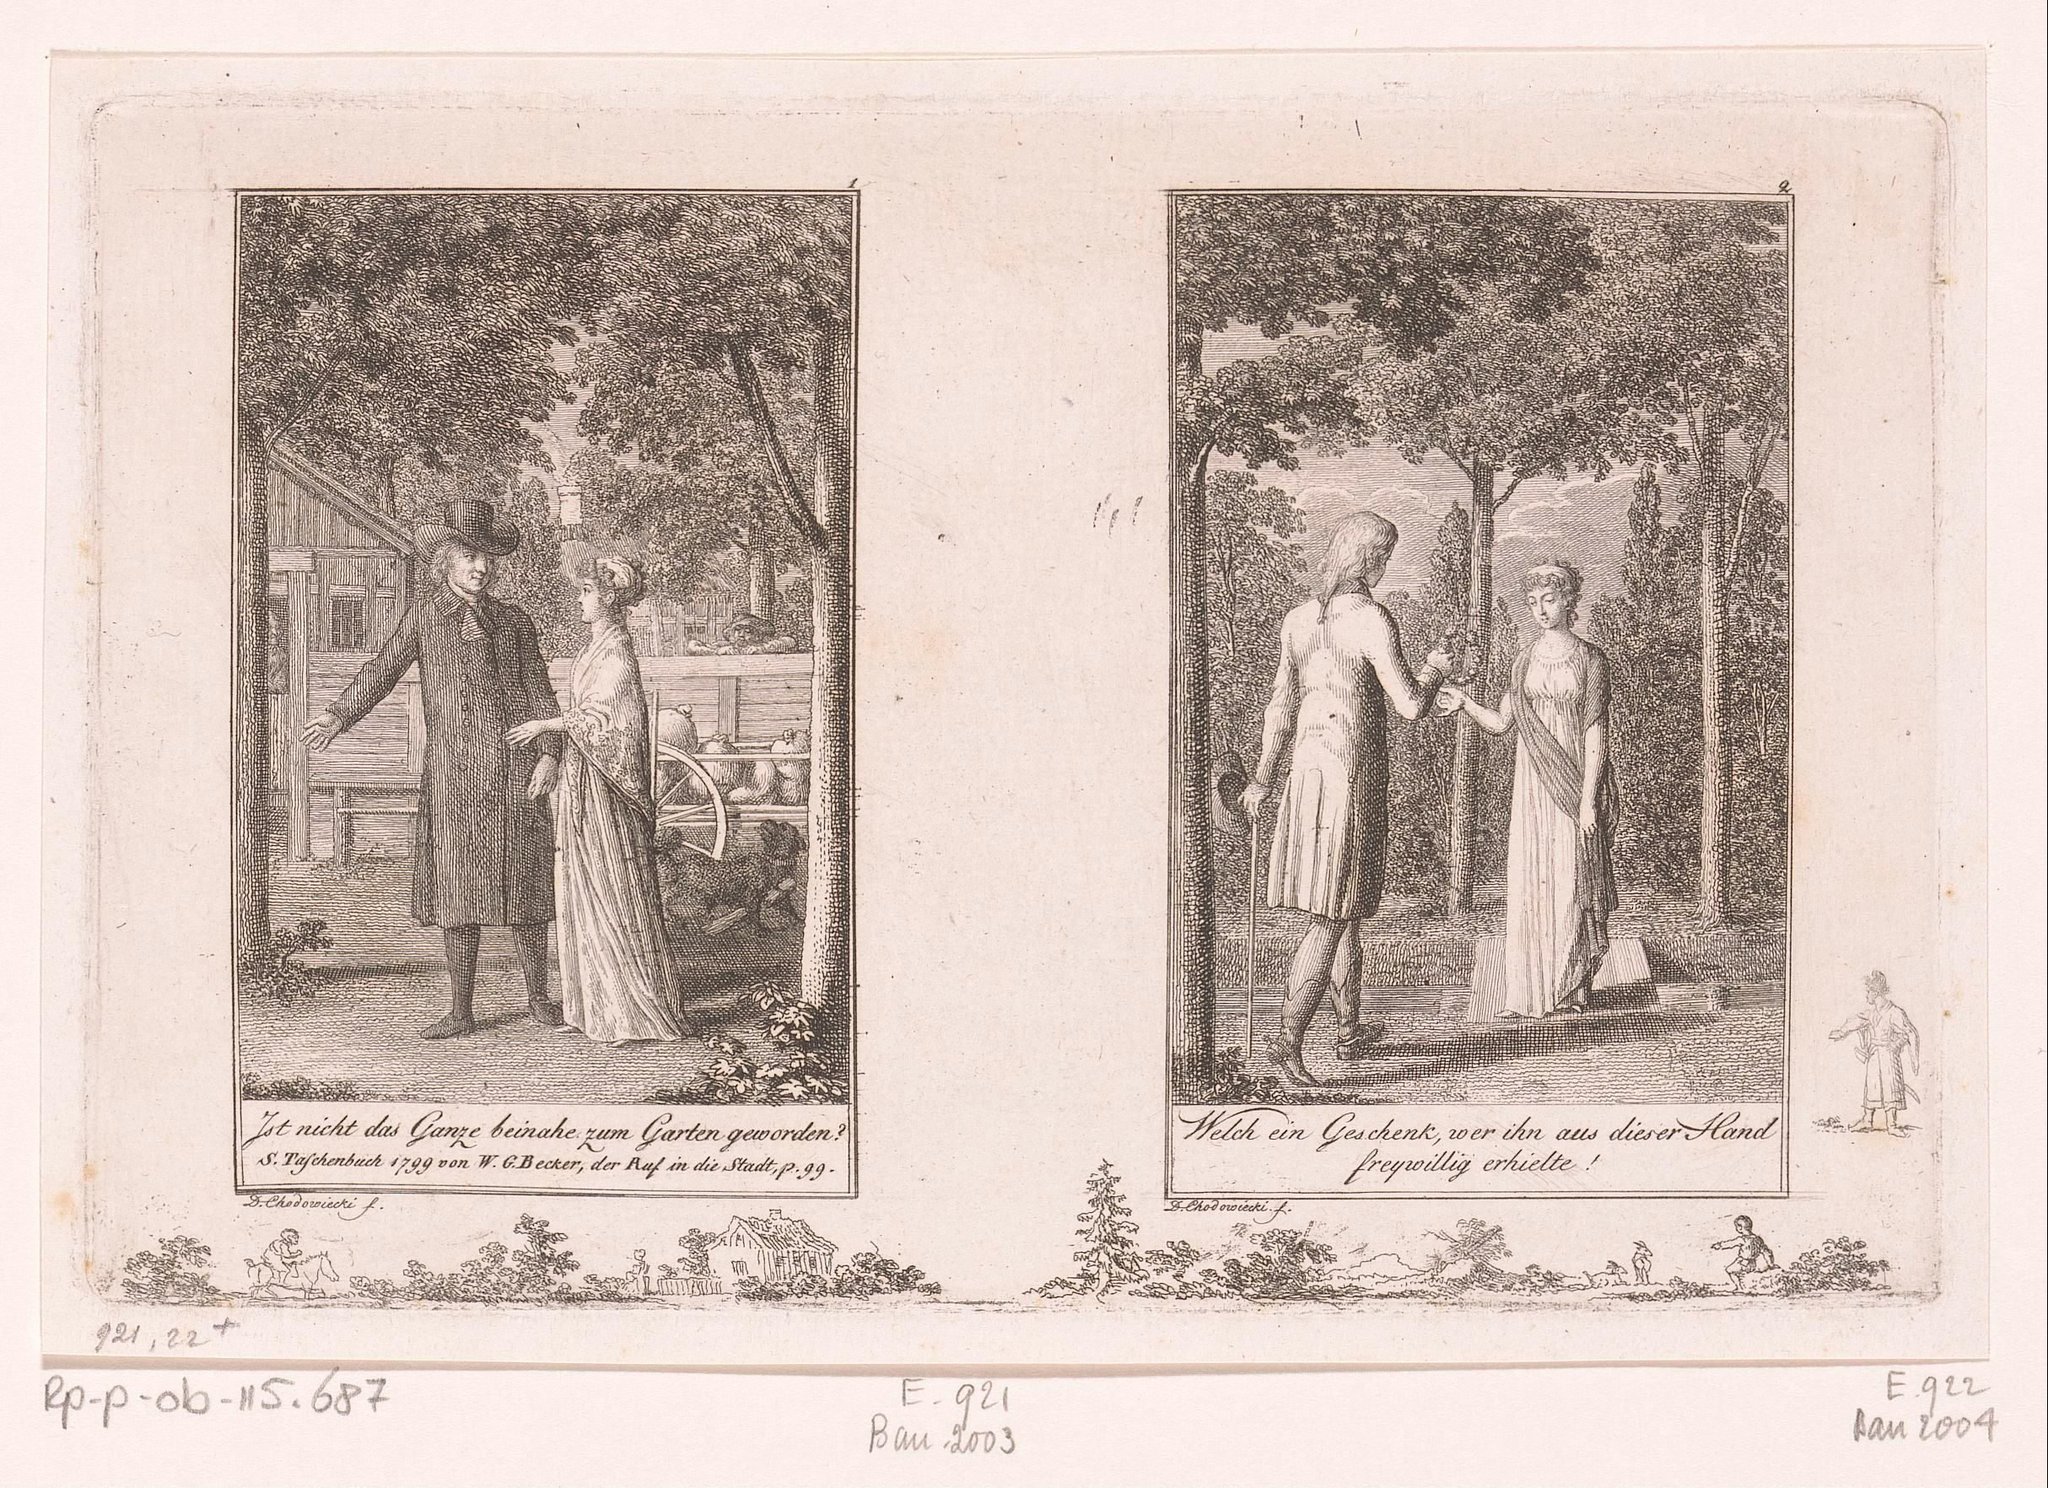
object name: print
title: Twee voorstellingen uit de verhalen van Wilhelm Gottlieb Becker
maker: daniel nikolaus chodowiecki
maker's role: draughtsman, print maker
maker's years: 1726-1801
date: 1800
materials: paper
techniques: etching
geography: berlin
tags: gifts being accepted, garland, wreath, garden, functionaries and dignitaries ~ protestant churches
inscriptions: collector's mark: Lugt 2228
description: De prenten zijn rechtsboven genummerd. Met onderschrift en paginaverwijzing in het Duits. In de marge zijn op schetsmatige wijze verschillende figuren geëtst.